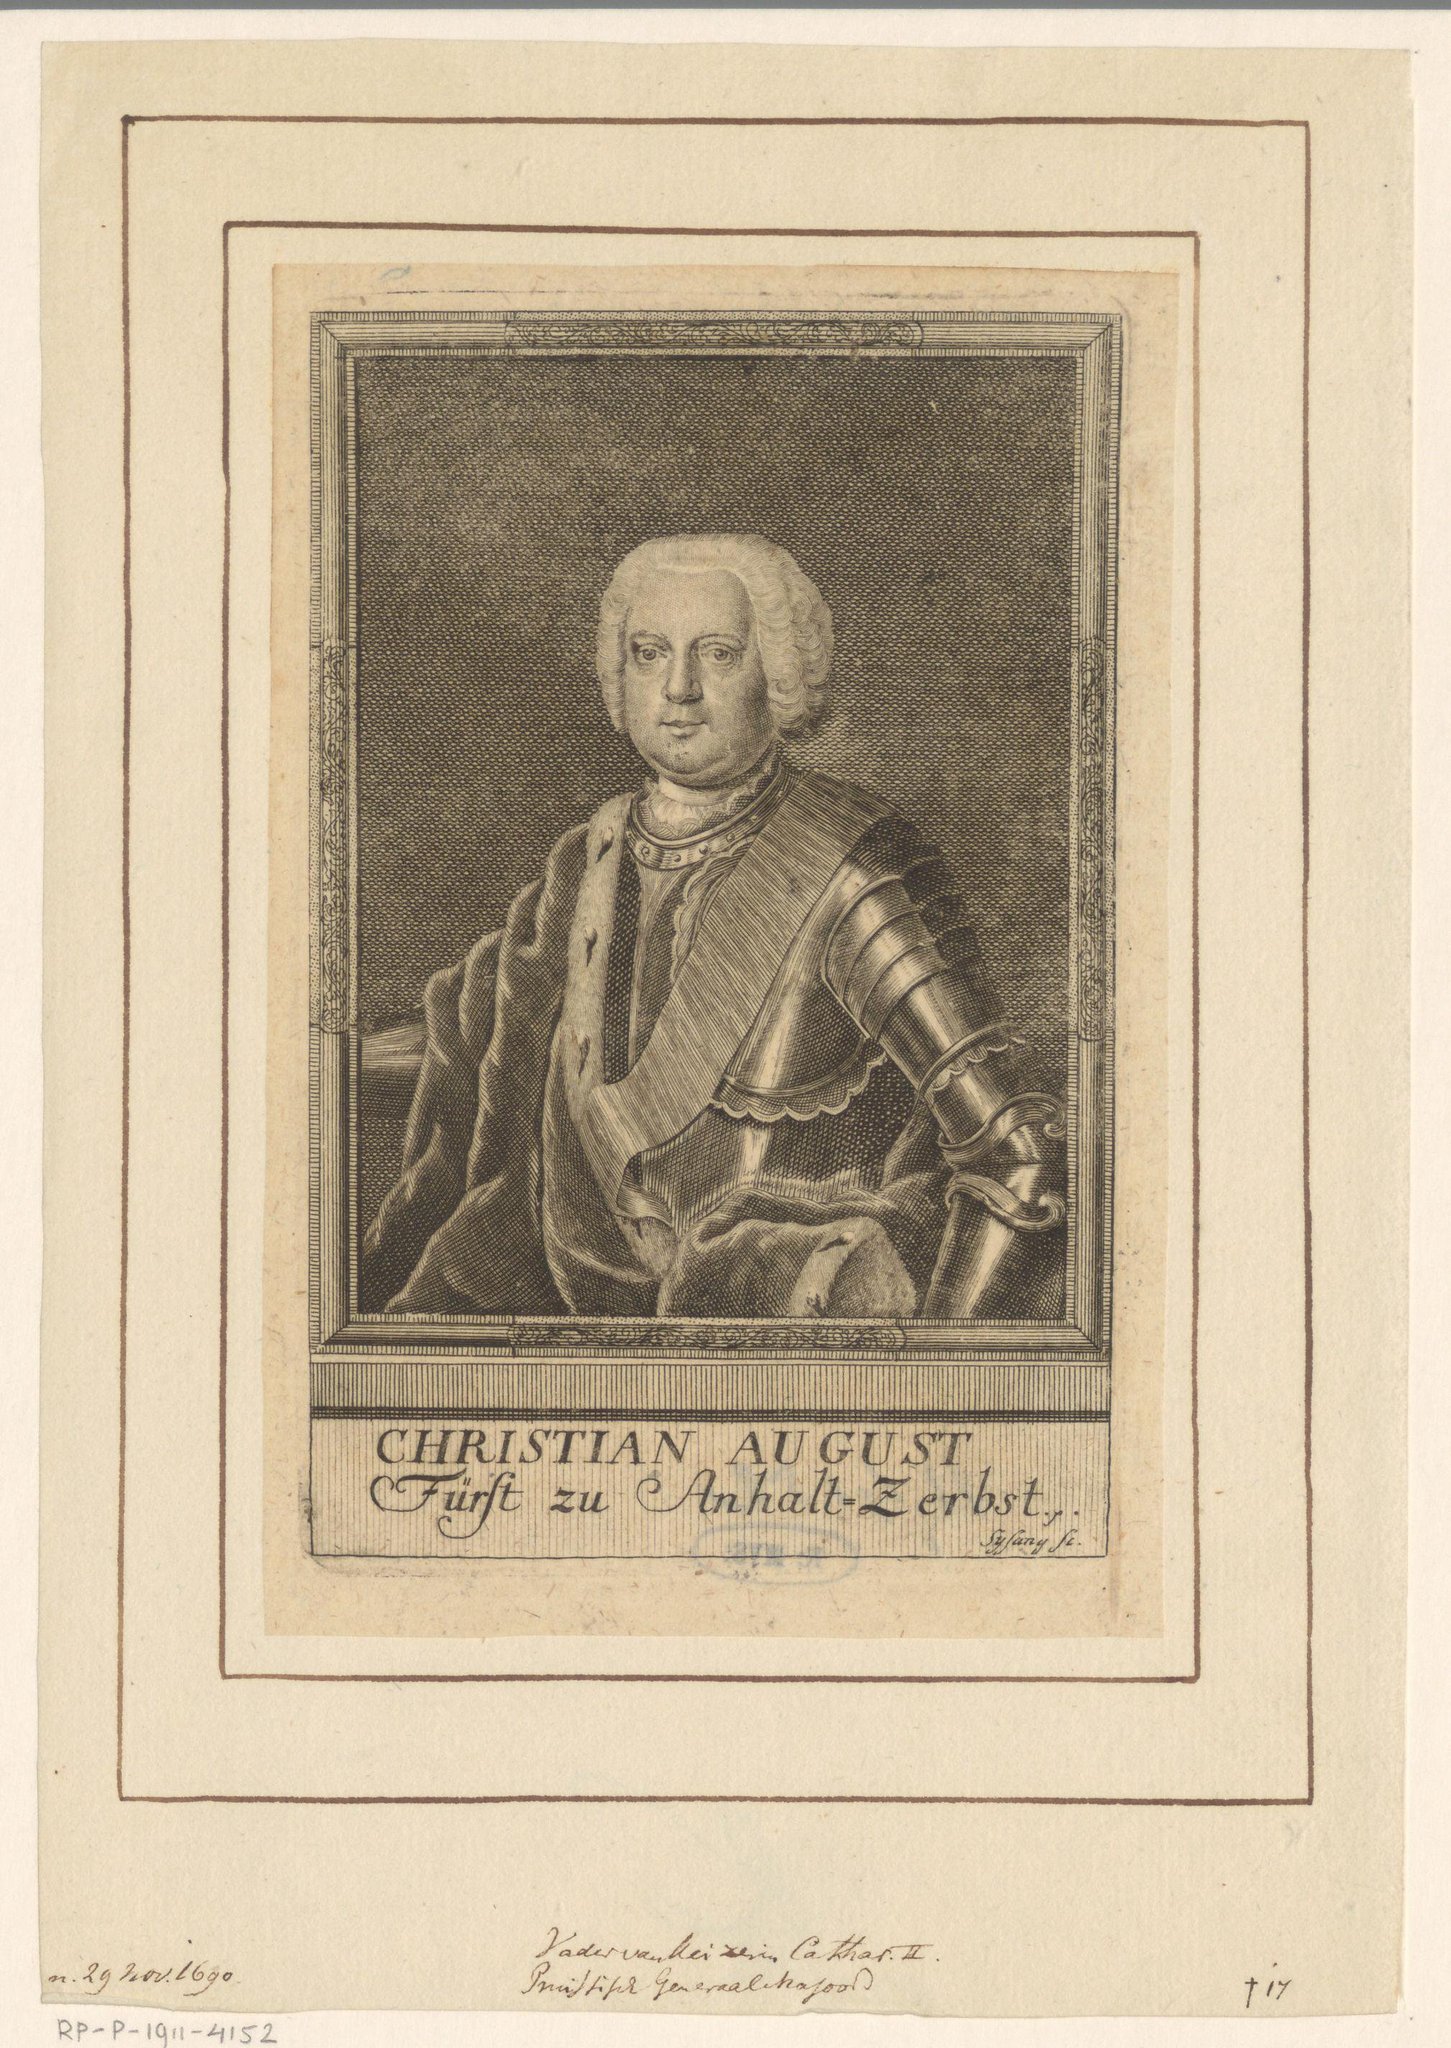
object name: print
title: Portret van Christian August, Fürst von Anhalt-Zerbst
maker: johann christoph sysang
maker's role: print maker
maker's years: 1703-1757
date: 1742-1757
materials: paper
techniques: engraving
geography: leipzig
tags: historical persons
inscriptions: collector's mark: Lugt 2228